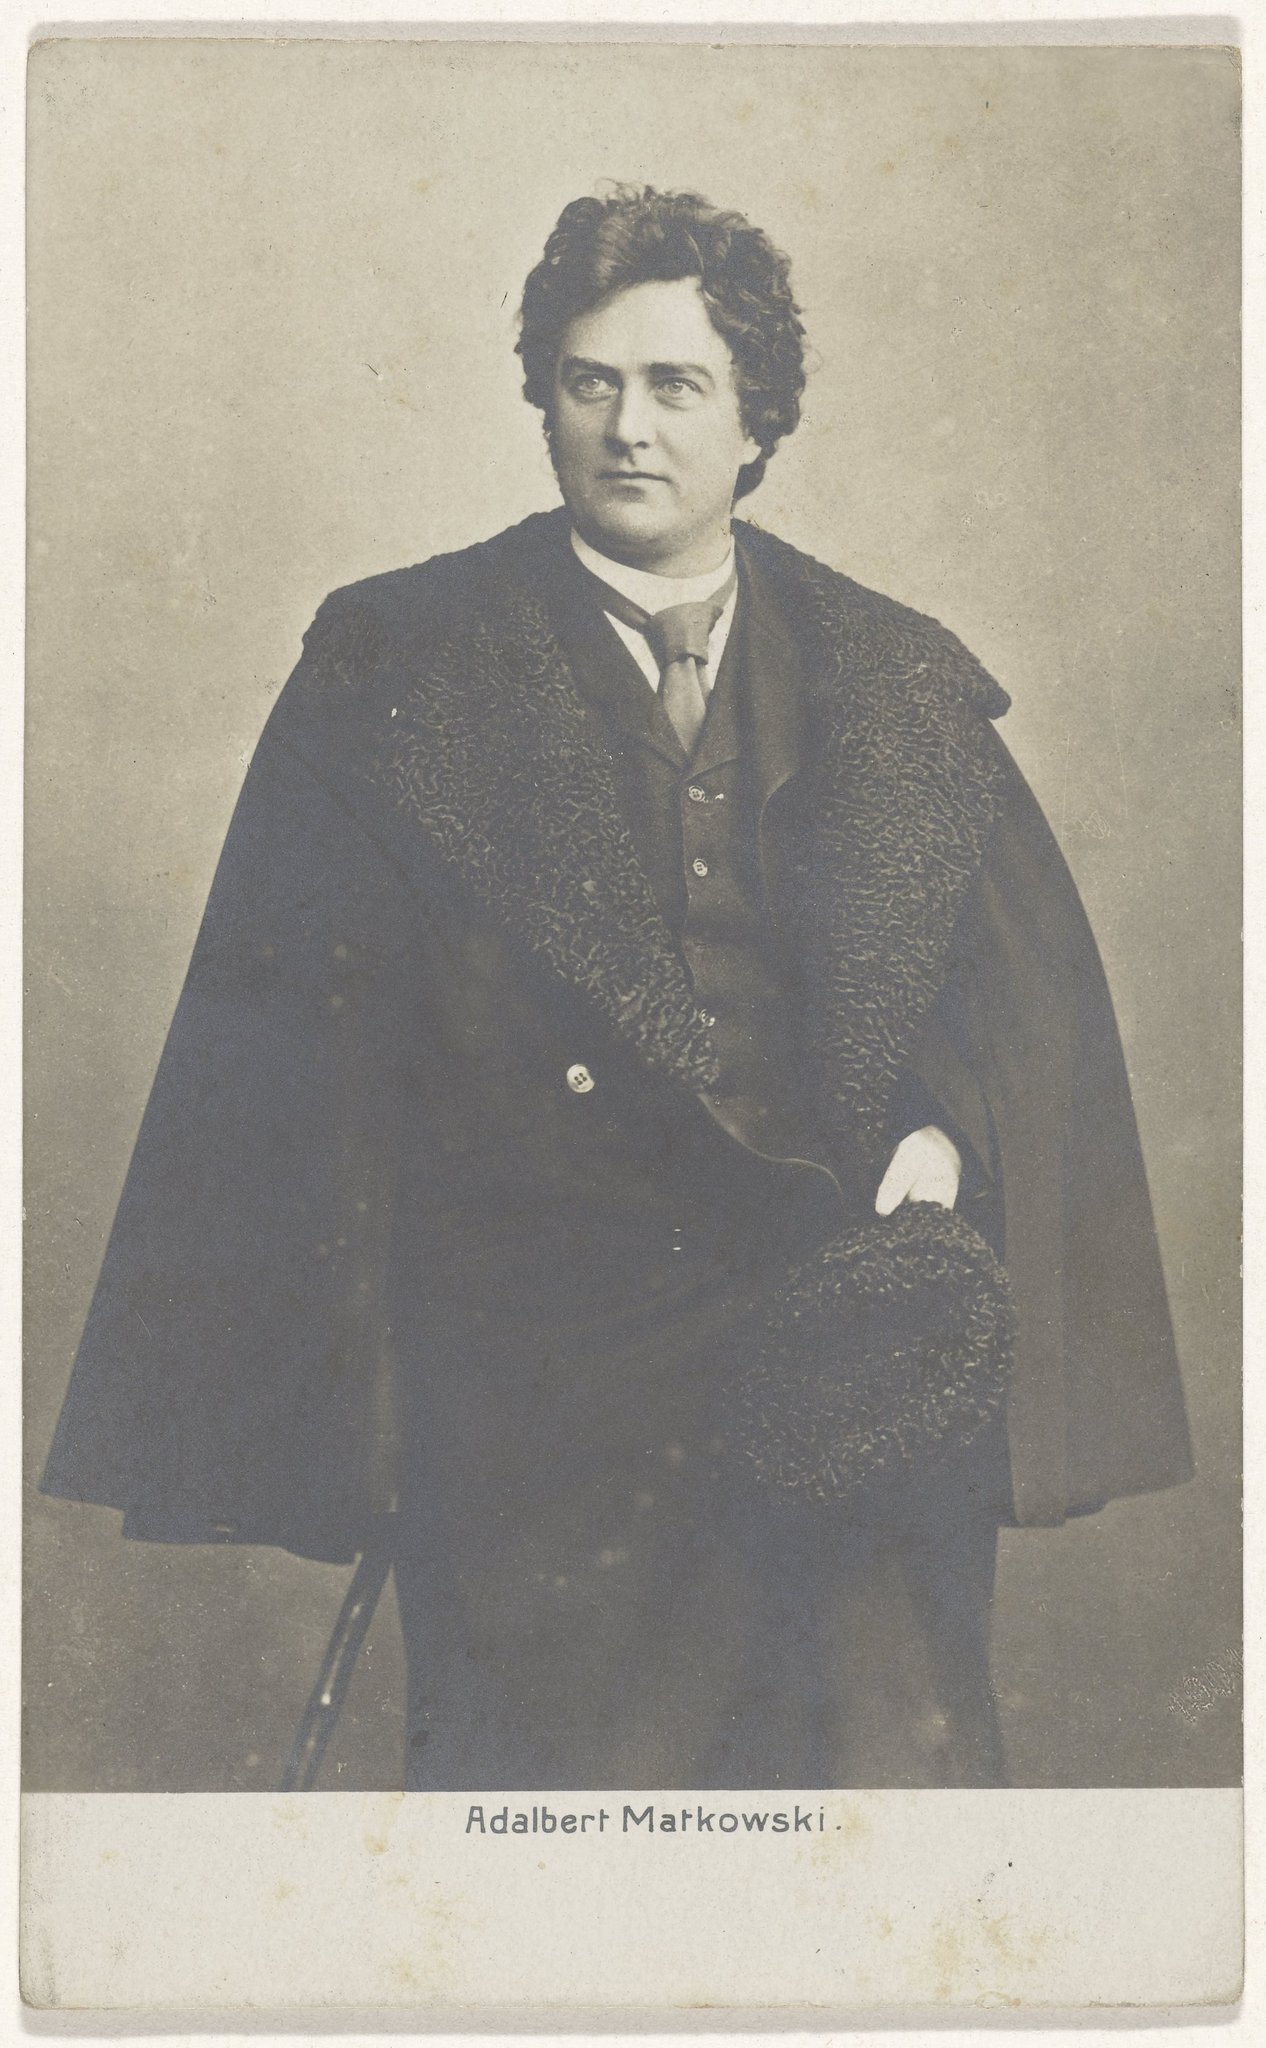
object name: photograph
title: Portret van Adalbert Markowski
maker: Anonymous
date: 1900-1940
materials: photographic support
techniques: gelatin silver print